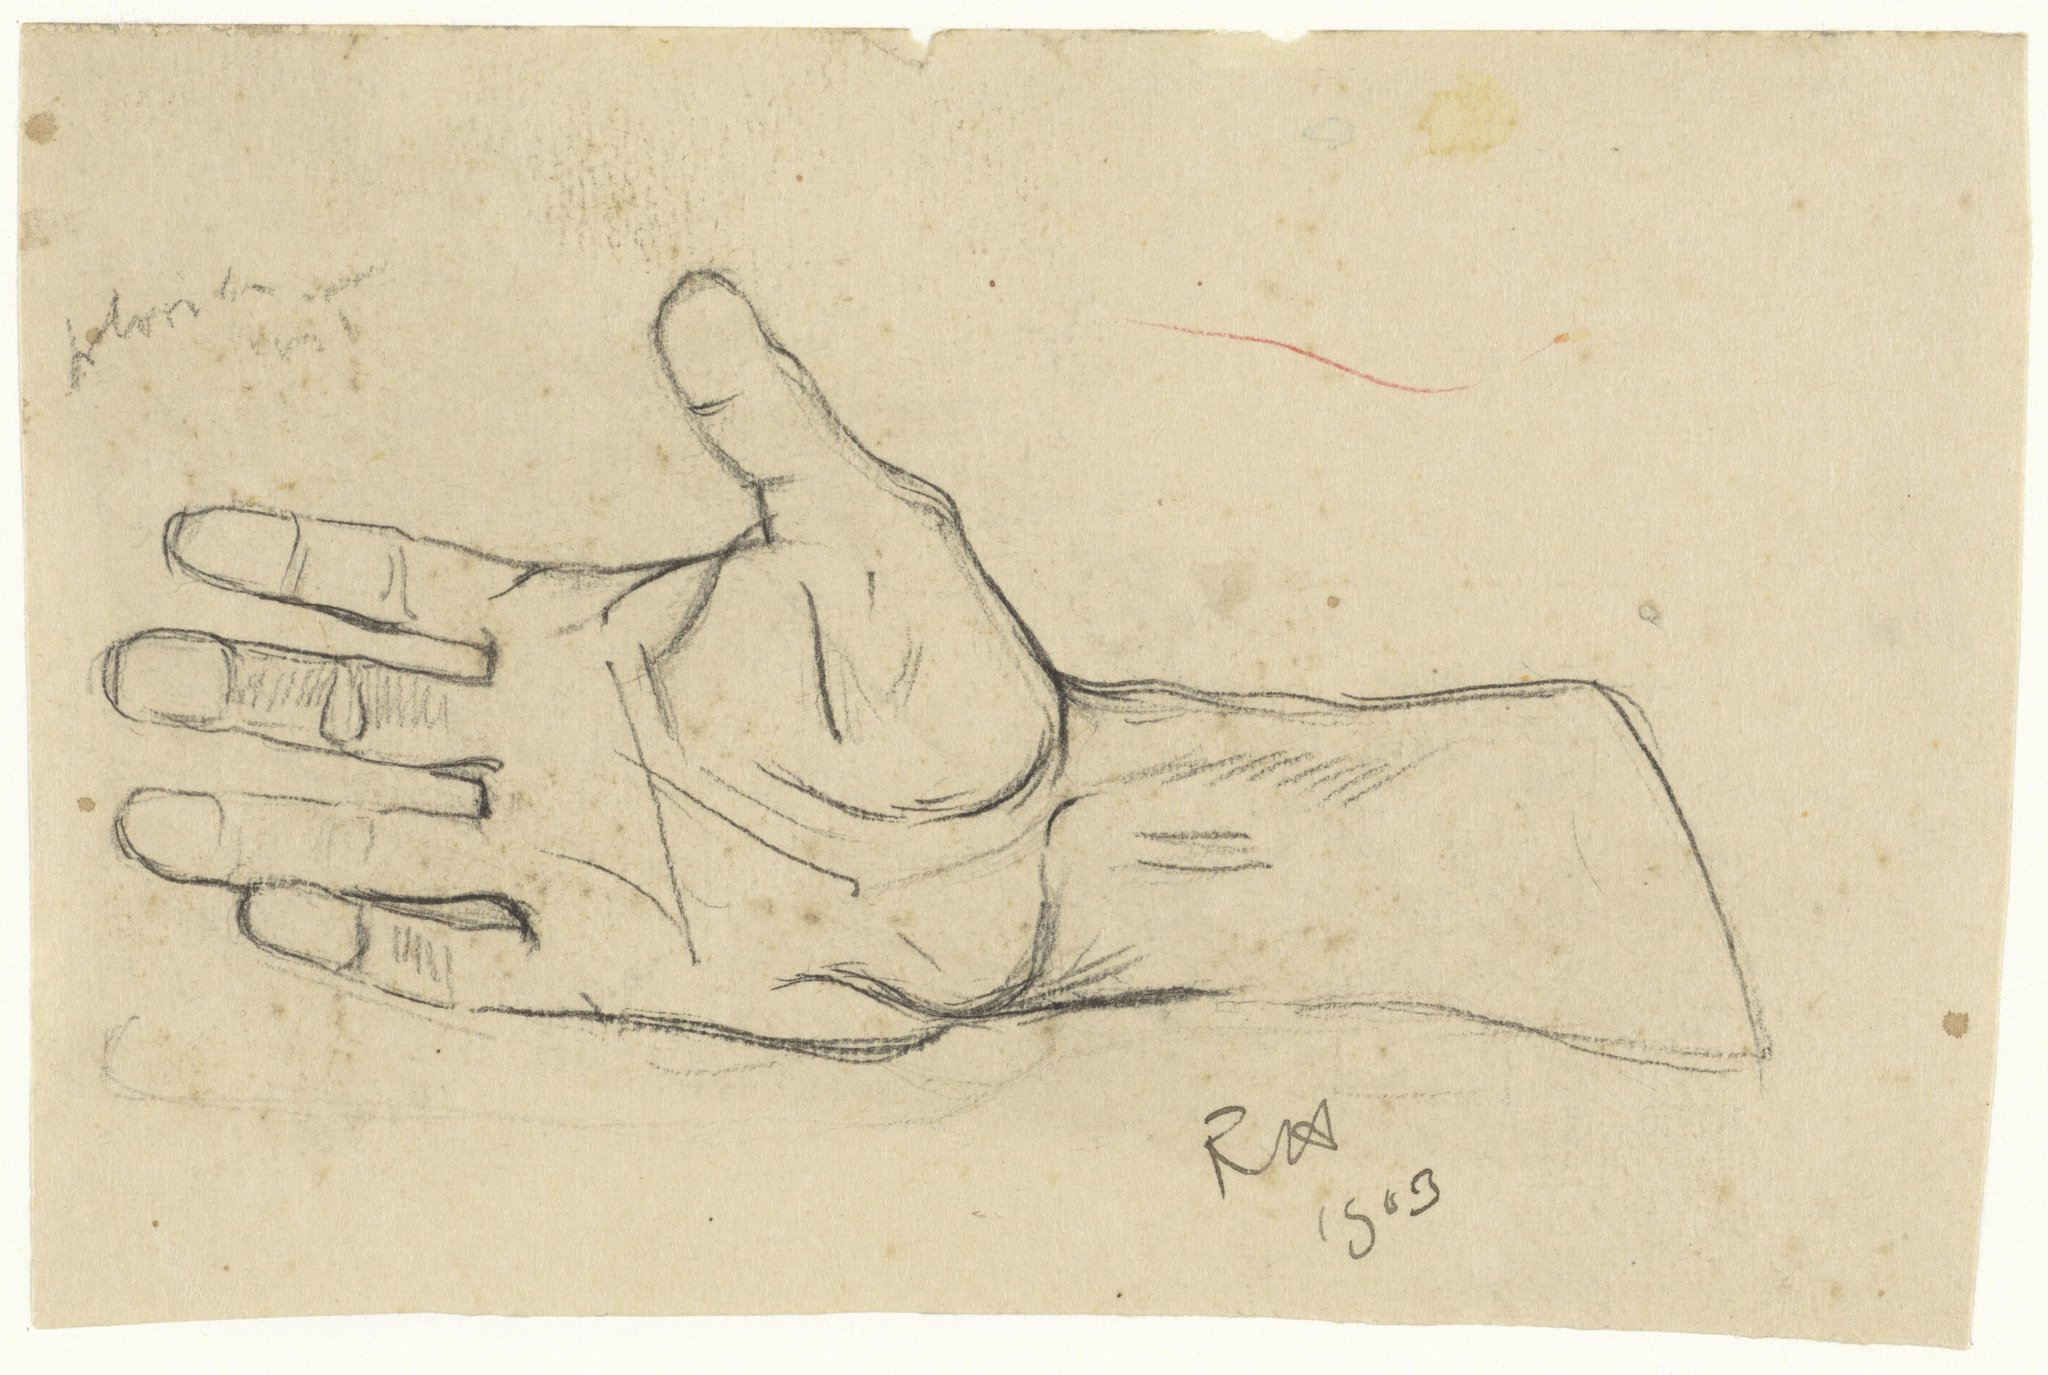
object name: drawing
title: Rechterhand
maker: richard nicolaüs roland holst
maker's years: 1868-1938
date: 1903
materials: chalk, paper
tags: hand